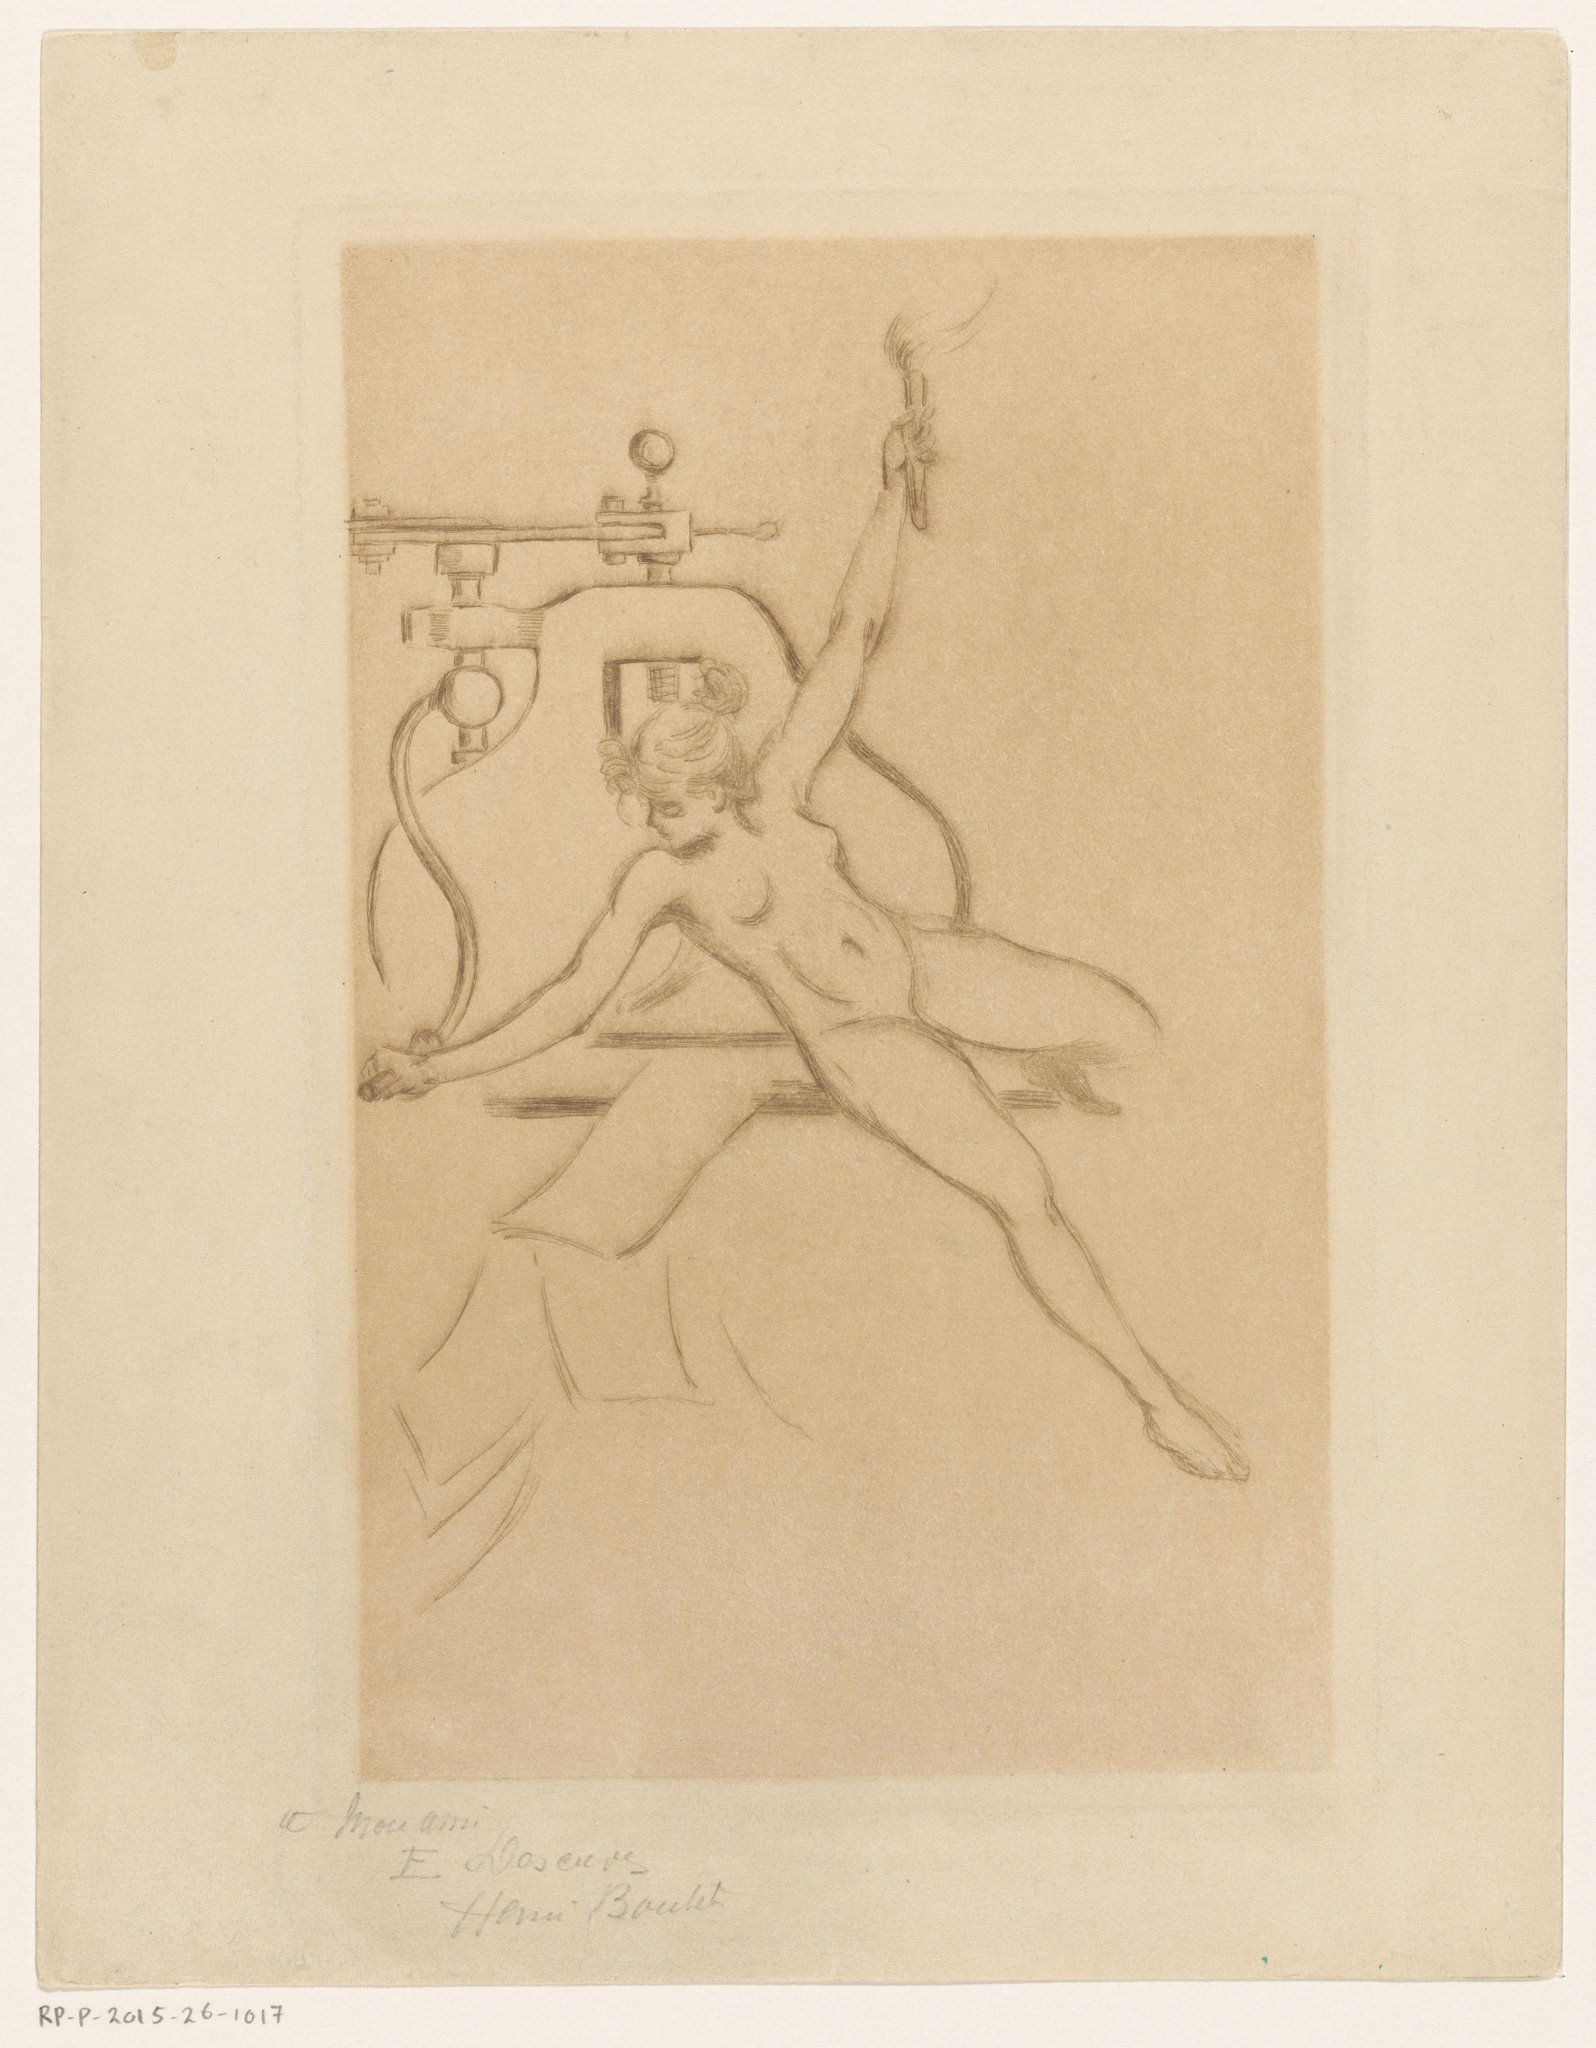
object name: print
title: Naakte vrouw met een fakkel in haar hand op een drukpers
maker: henri boutet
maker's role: draughtsman, print maker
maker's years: 1851-1919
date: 1894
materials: paper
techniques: drypoint, intaglio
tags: torch, print, e.g.: engraving, etching, lithograph, printing press, woman (showing herself) undressed, quasi-nude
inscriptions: collector's mark: Lugt 2228, collector's mark: Lugt 4779, dedication: ‘a mon ami E. Doseurs [?] Henri Boutet’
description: Deze prent werd ook gebruikt voor de menukaart van een diner door een gezelschap van meesterdrukkers, gehouden op 10 mei 1894 ter ere van Saint-Jean Porte-Latine, de beschermheilige van de drukkers.